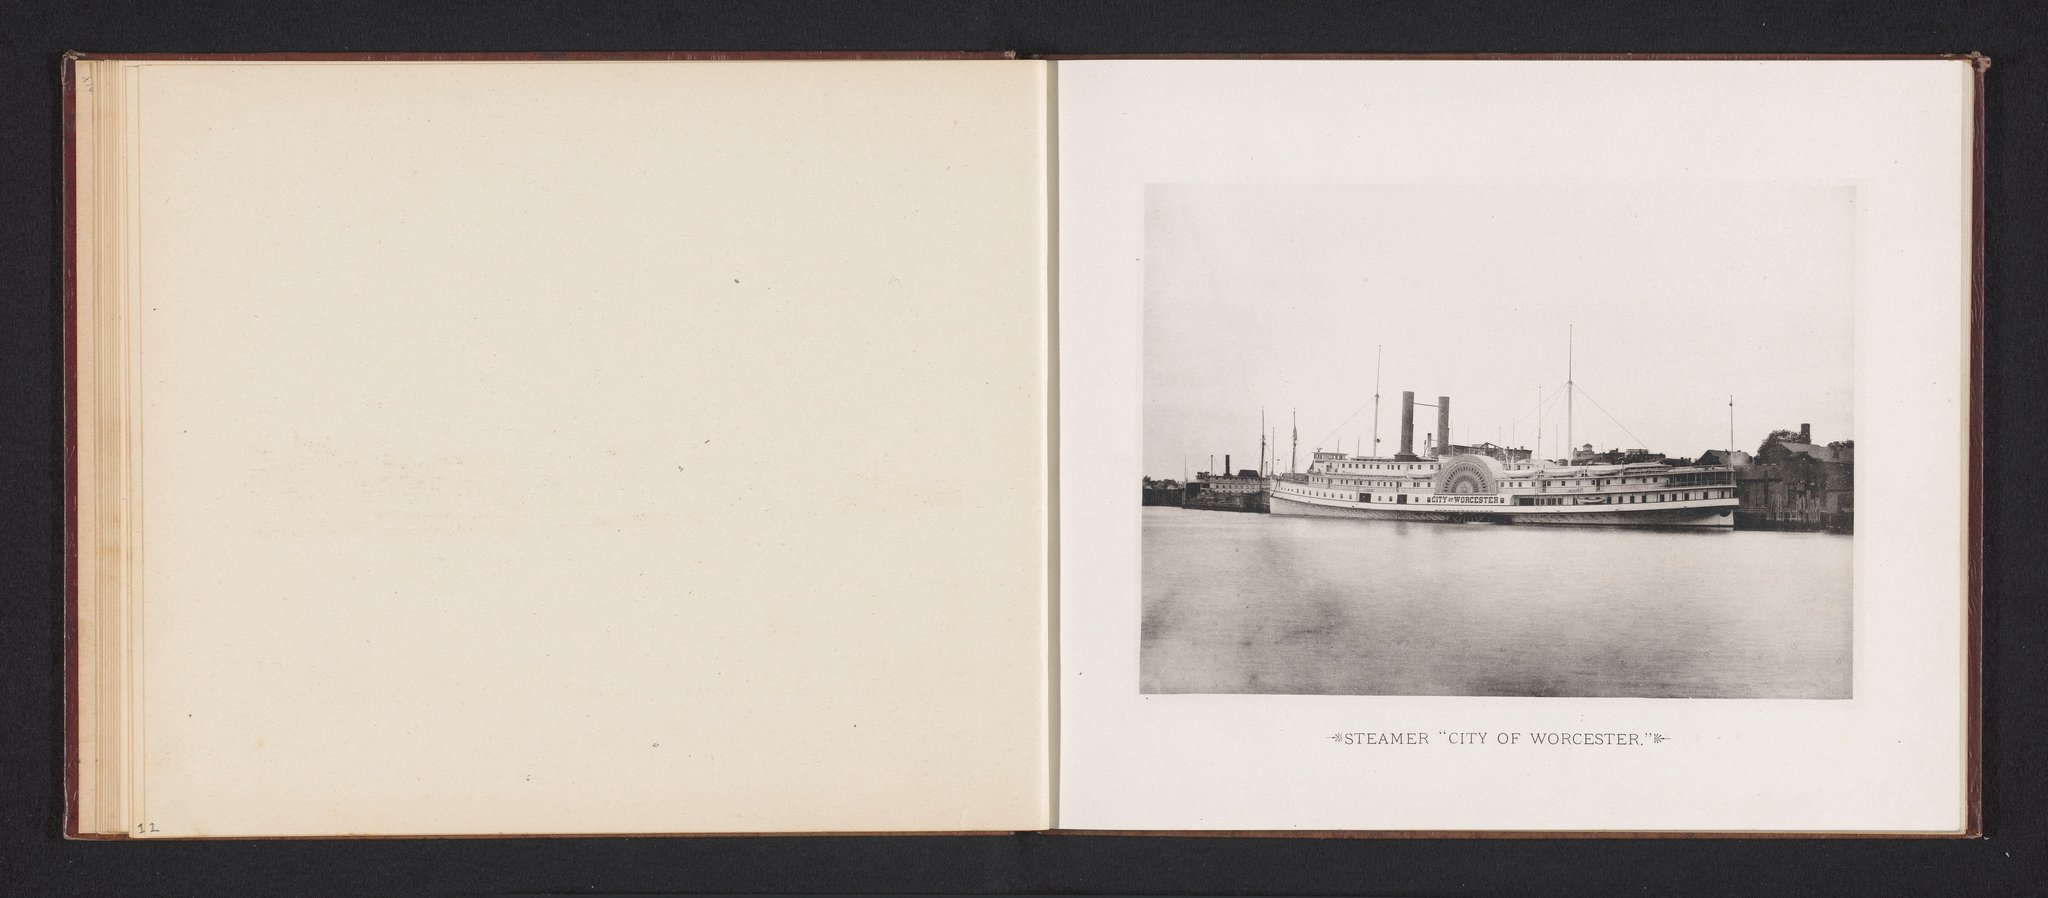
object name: page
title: Gezicht op een stoomboot in Worcester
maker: Anonymous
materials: paper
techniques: photograph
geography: worcester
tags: ships (in general)